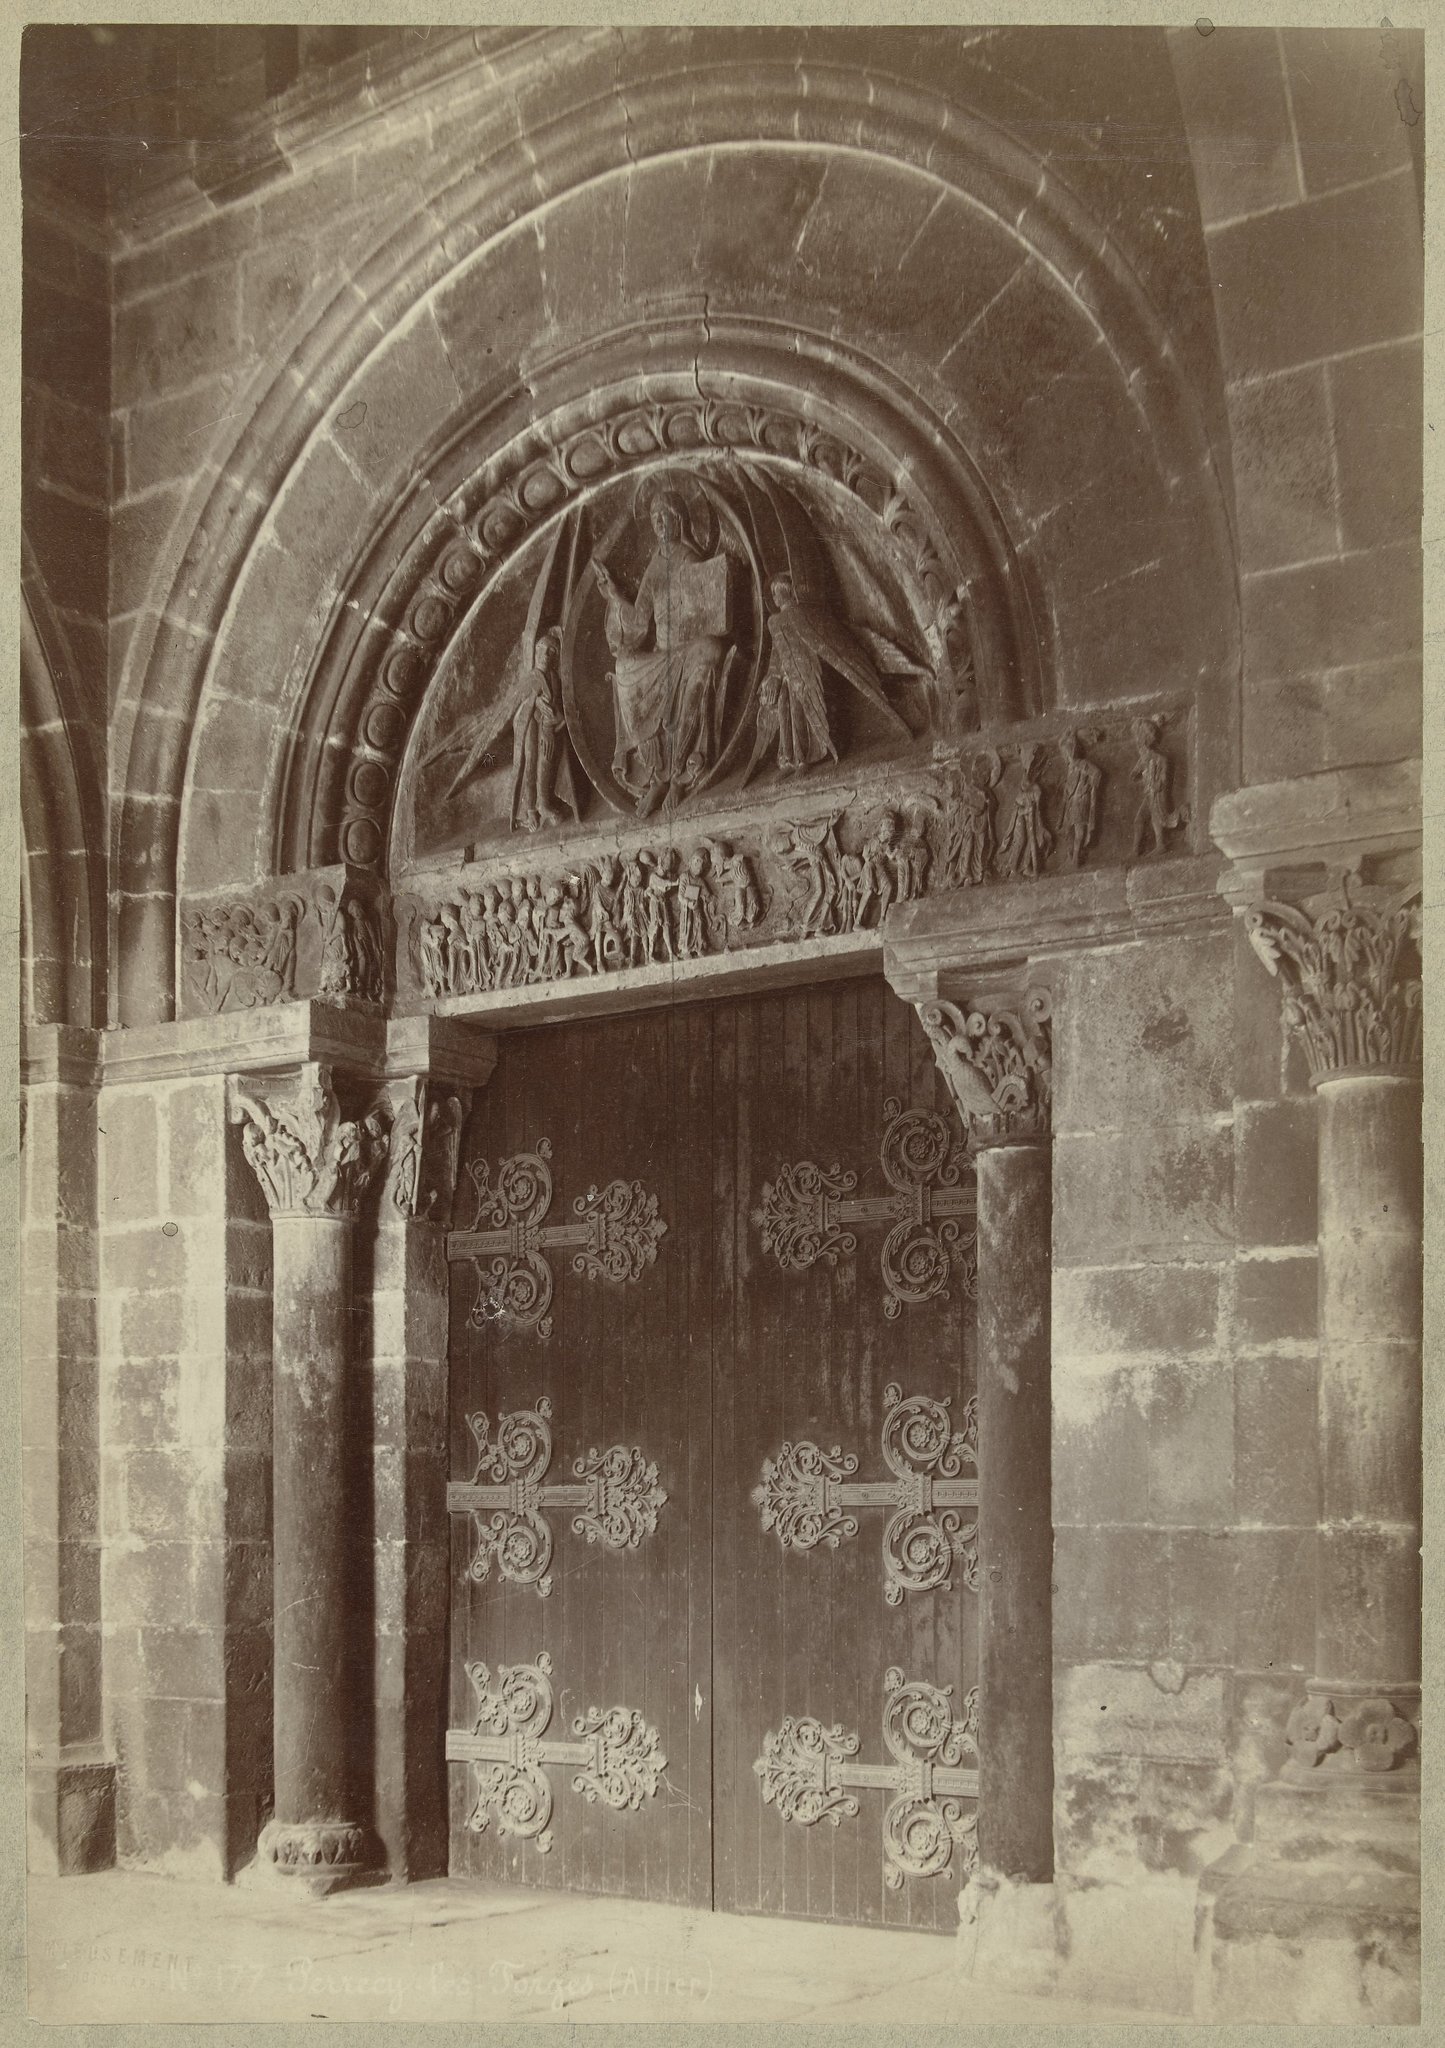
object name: photograph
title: Perrecy-les-Forges (Allier)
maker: séraphin-médéric mieusement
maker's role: fotograaf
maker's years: 1840-1905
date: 1870-1890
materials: cardboard, paper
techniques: albumen print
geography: perrecy-les-forges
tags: parts of church exterior and annexes: portal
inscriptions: inscription: ‘No. 177 Perrecy-les-Forges (Allier)’, inscription: ‘Perrey-les-Forges (Allier)’, check stamp: ‘Mieusement/ Photographe’, collector's mark: Lugt 3937